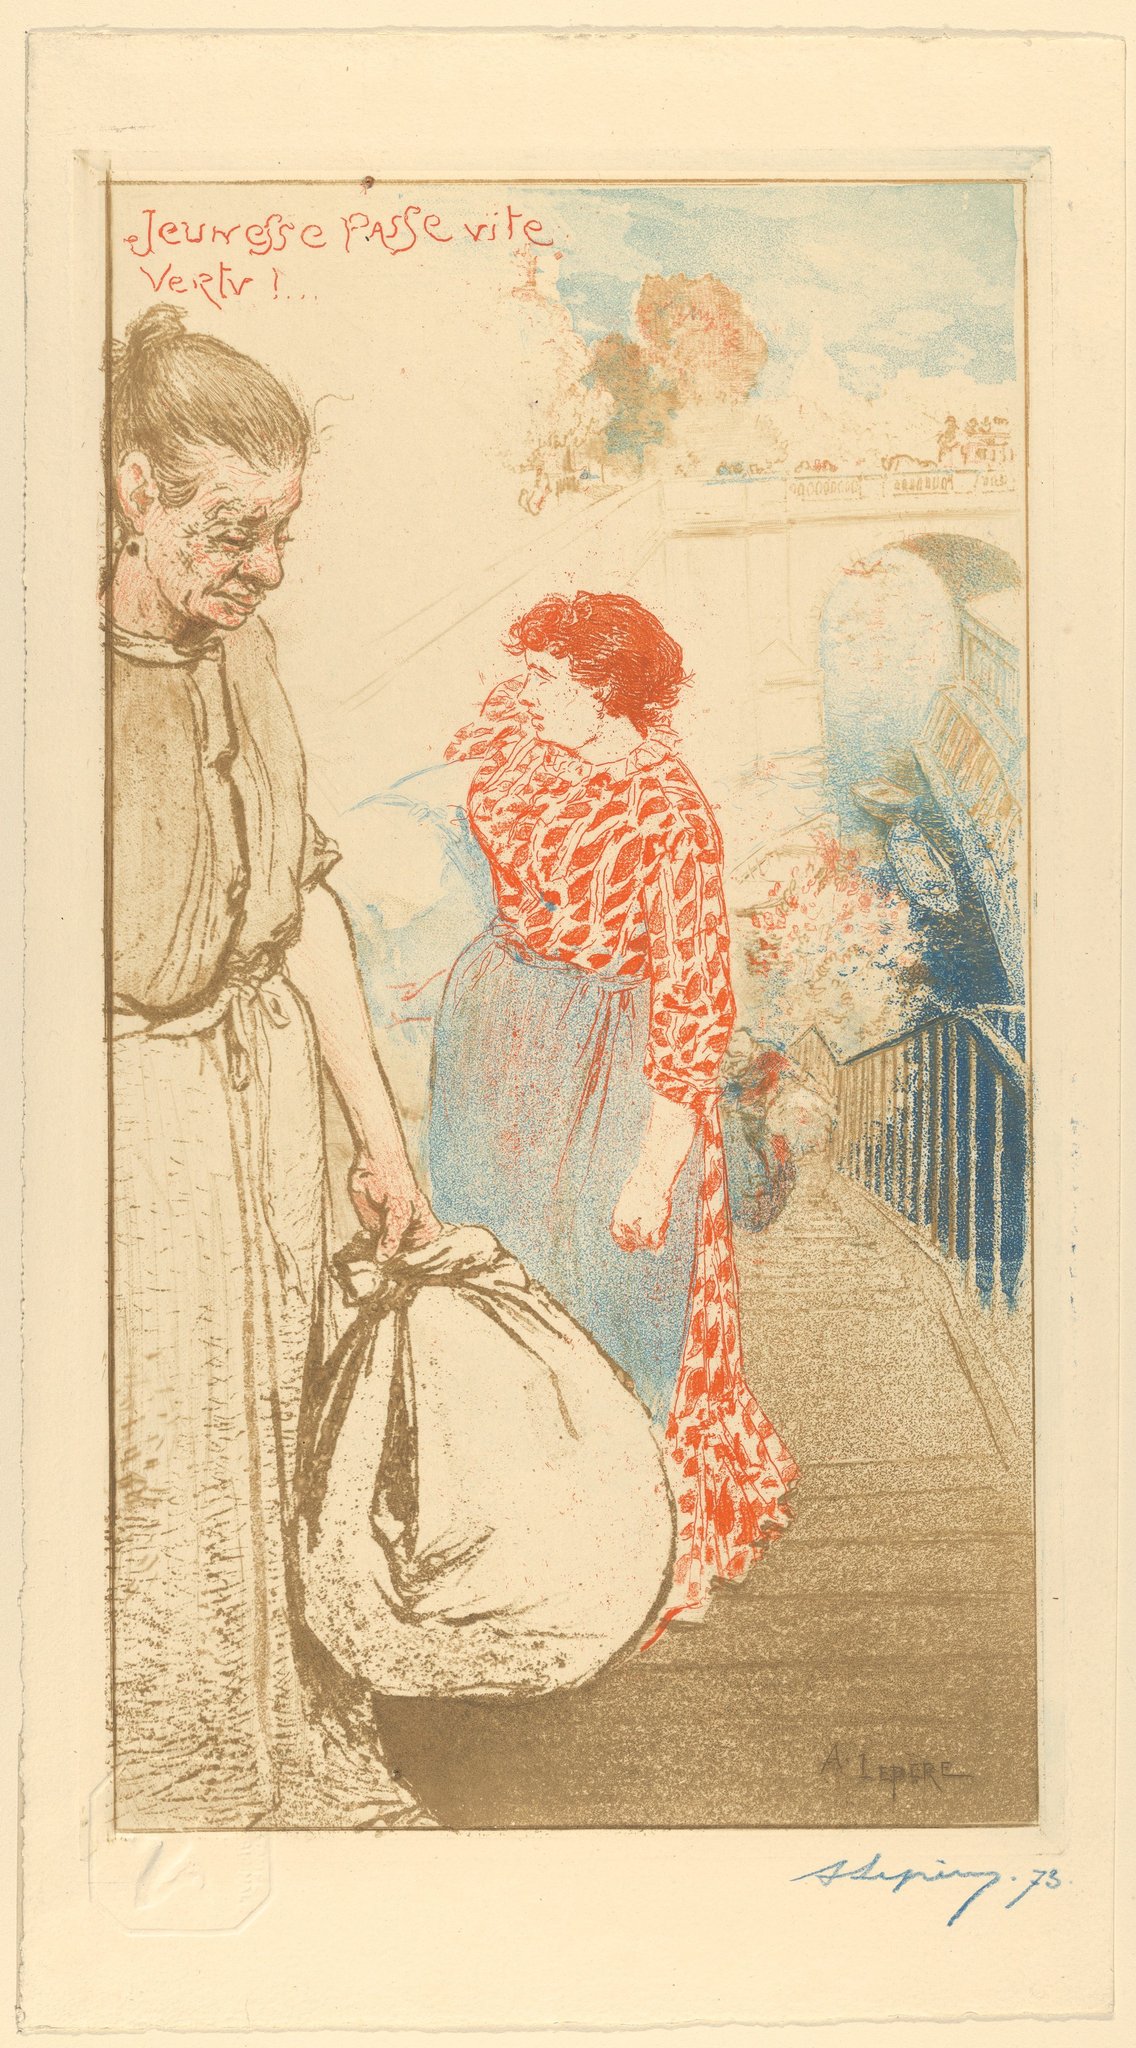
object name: print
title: Laundresses (Blanchisseuses) (How Quickly Youth Fades! / Jeunesse passe vite vertu!), from "L'Estampe Originale"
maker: auguste-louis lepère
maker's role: artist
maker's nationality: french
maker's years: 1849-1918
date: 1893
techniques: aquatint, printing, etching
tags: women